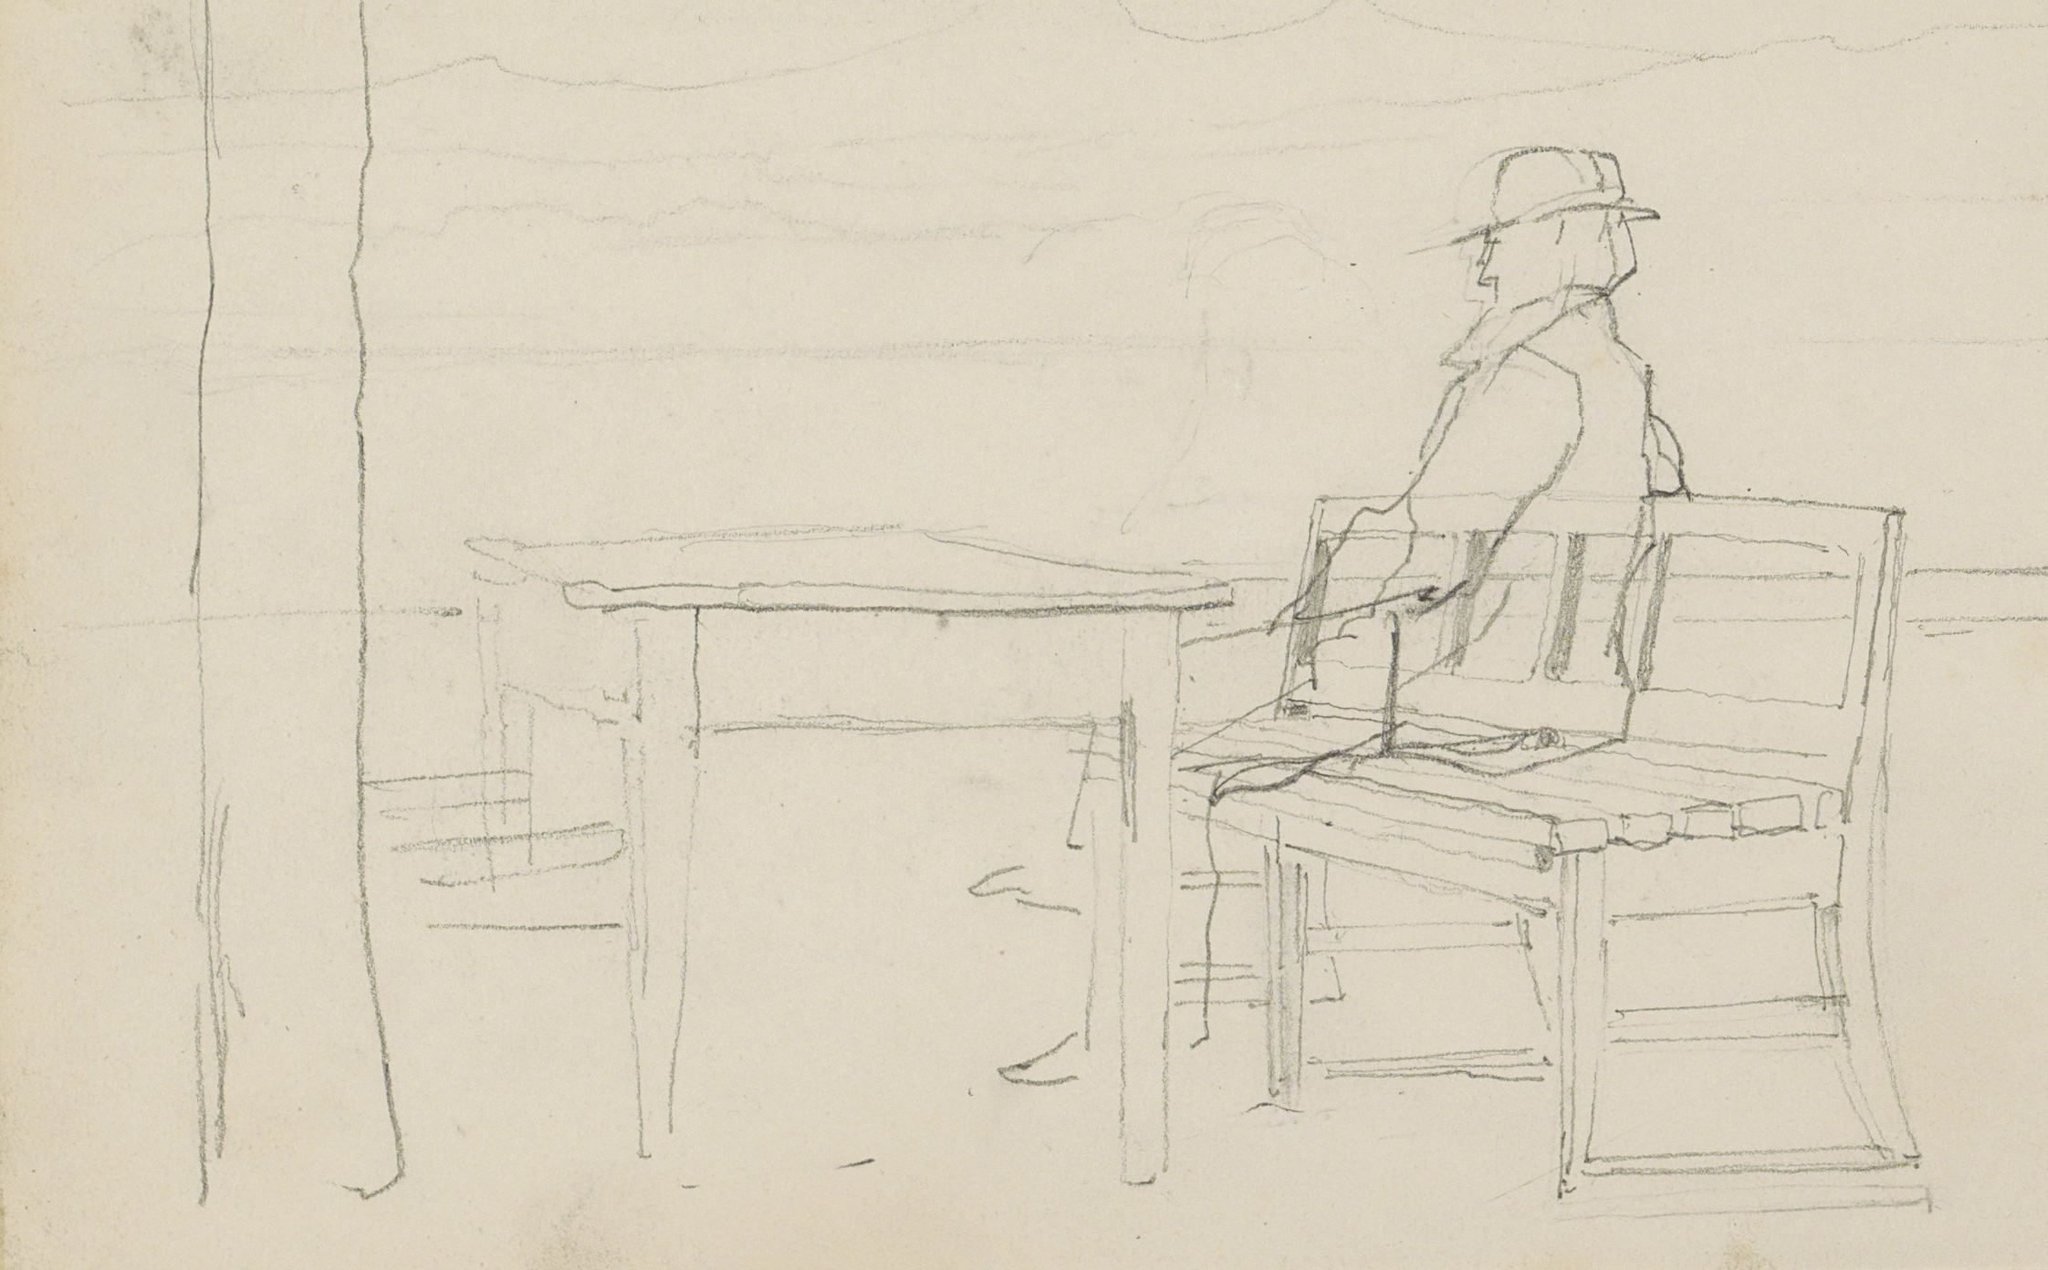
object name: sketchbook leaf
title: Man zittend op een bank met uitzicht op water en bergen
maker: anton mauve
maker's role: draughtsman, painter, print maker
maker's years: 1838-1888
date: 1848-1888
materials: paper, pencil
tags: sitting figure (+ male human being (not to be used where -a- is prescribed)), mountains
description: Blad 14 verso uit een schetsboek met 42 bladen.